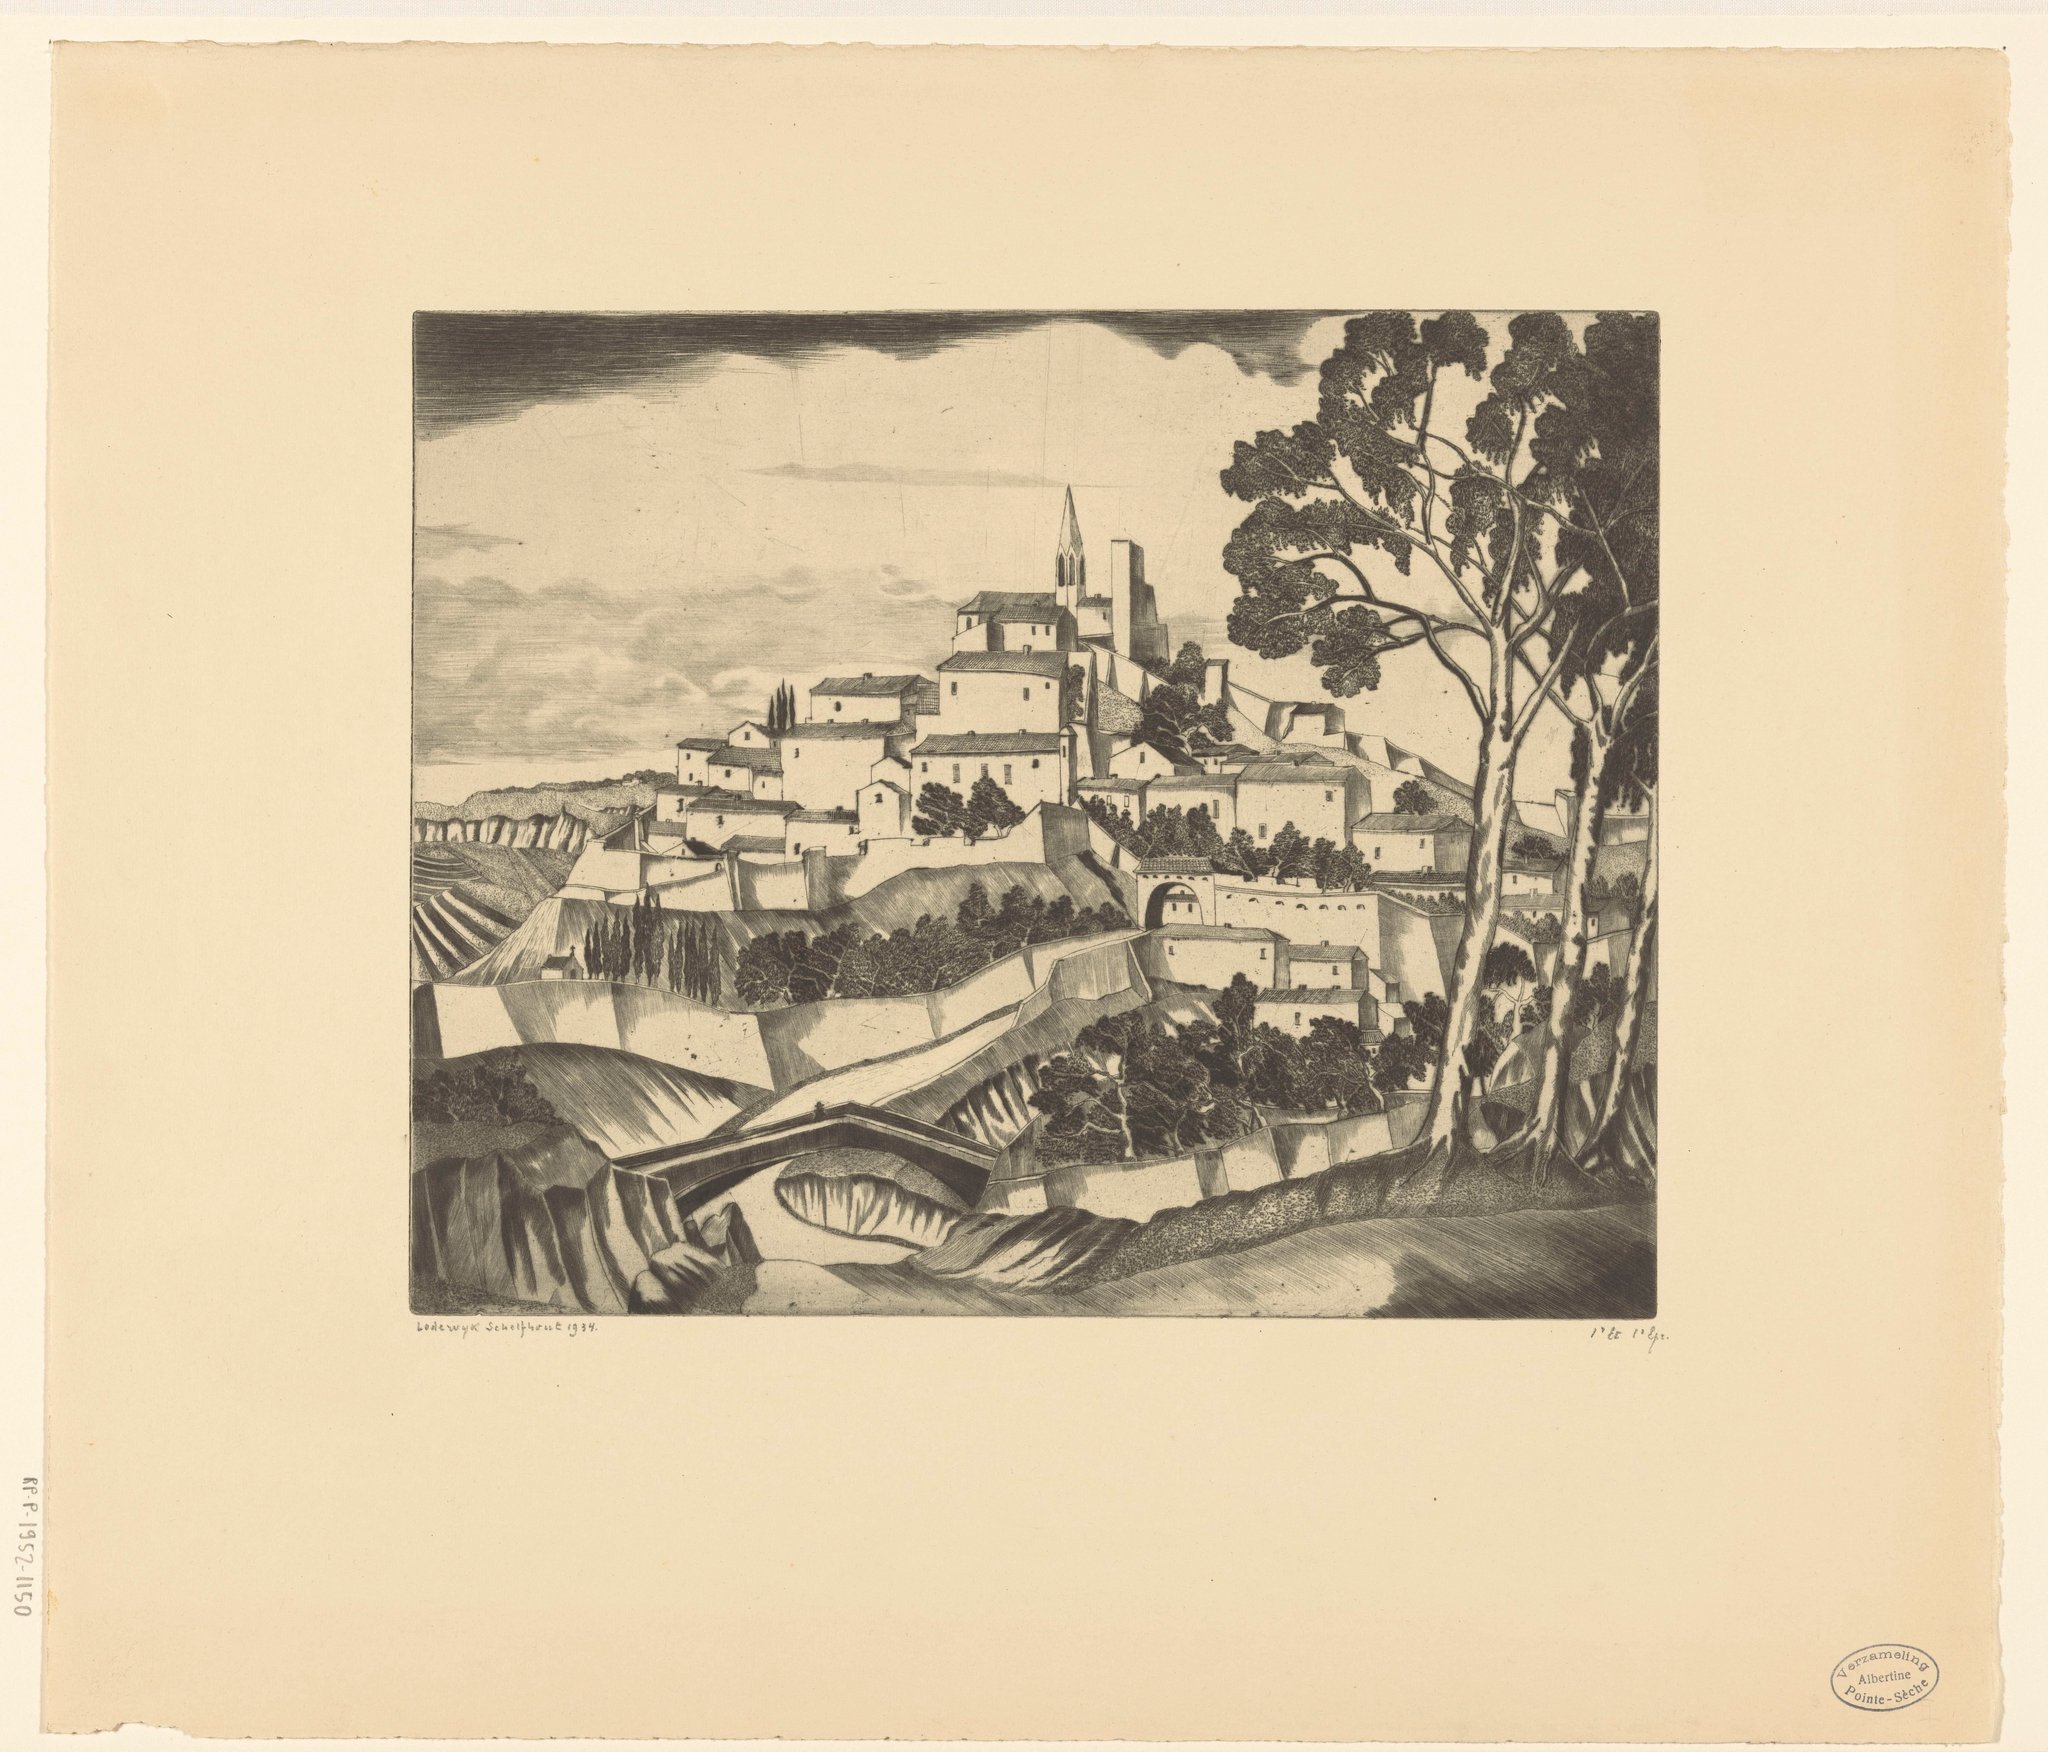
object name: print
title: Les Angles III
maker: lodewijk schelfhout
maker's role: draughtsman, print maker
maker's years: 1881-1943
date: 1934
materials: paper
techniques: drypoint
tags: low hill country, village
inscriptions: collector's mark: Lugt 2228, collector's mark: Lugt 5i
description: Het dorp Les Angles, gelegen op een heuvel nabij de stad Avignon in het zuiden van Frankrijk.